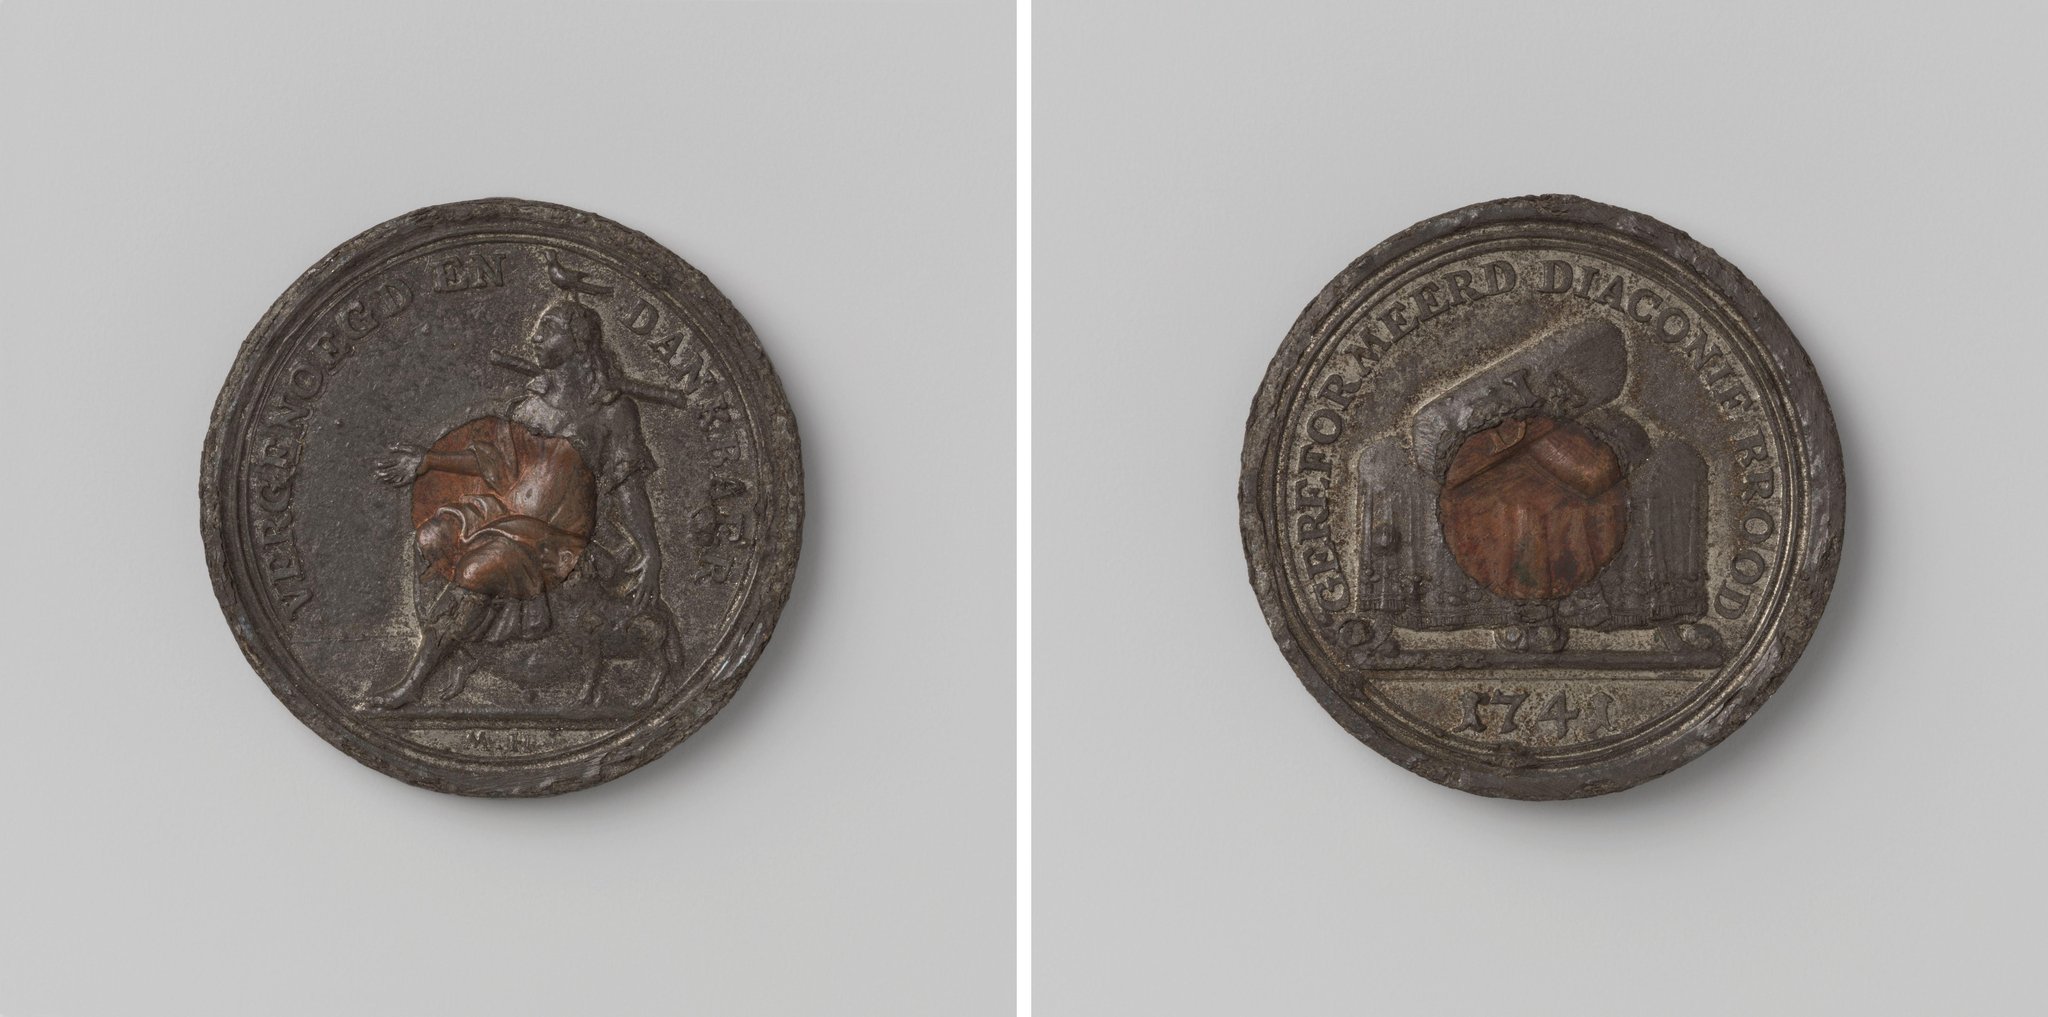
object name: broodpenning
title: Gereformeerde Diakonie te Amsterdam, armenpenning die behoeftige kerklidmaten bij uitdeling recht gaf op brood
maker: martinus holtzhey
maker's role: medailleur, muntmaker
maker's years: 1697-1764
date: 1741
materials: copper, lead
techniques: striking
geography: amsterdam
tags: amsterdam